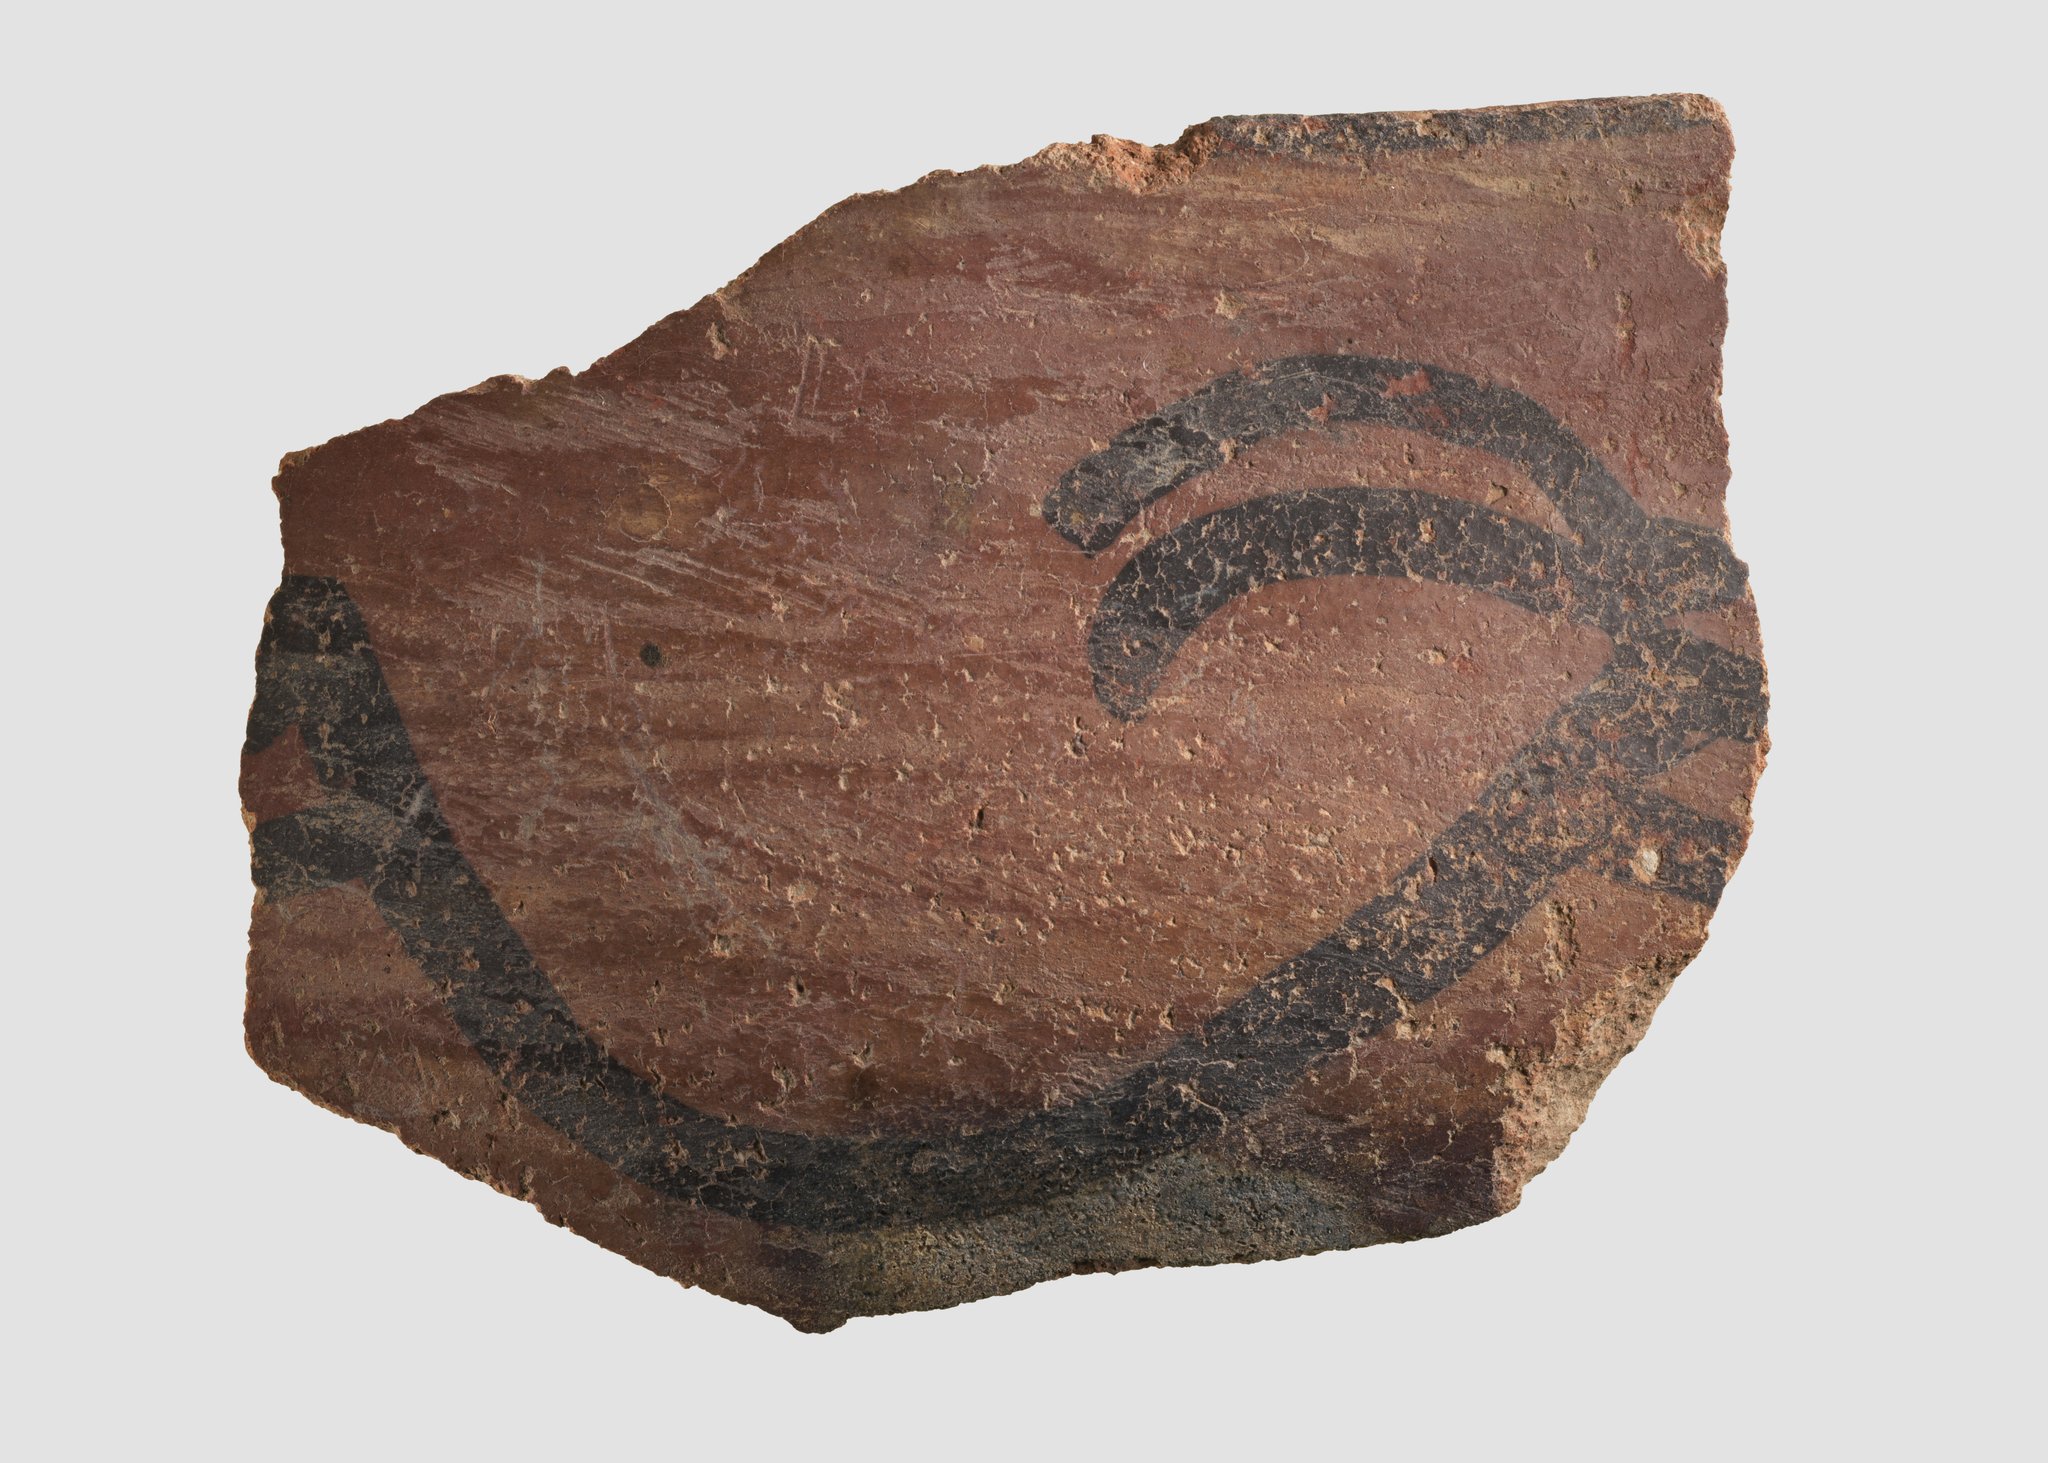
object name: sherd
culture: iranian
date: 3500-3100 BCE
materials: ceramic, paint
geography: iran